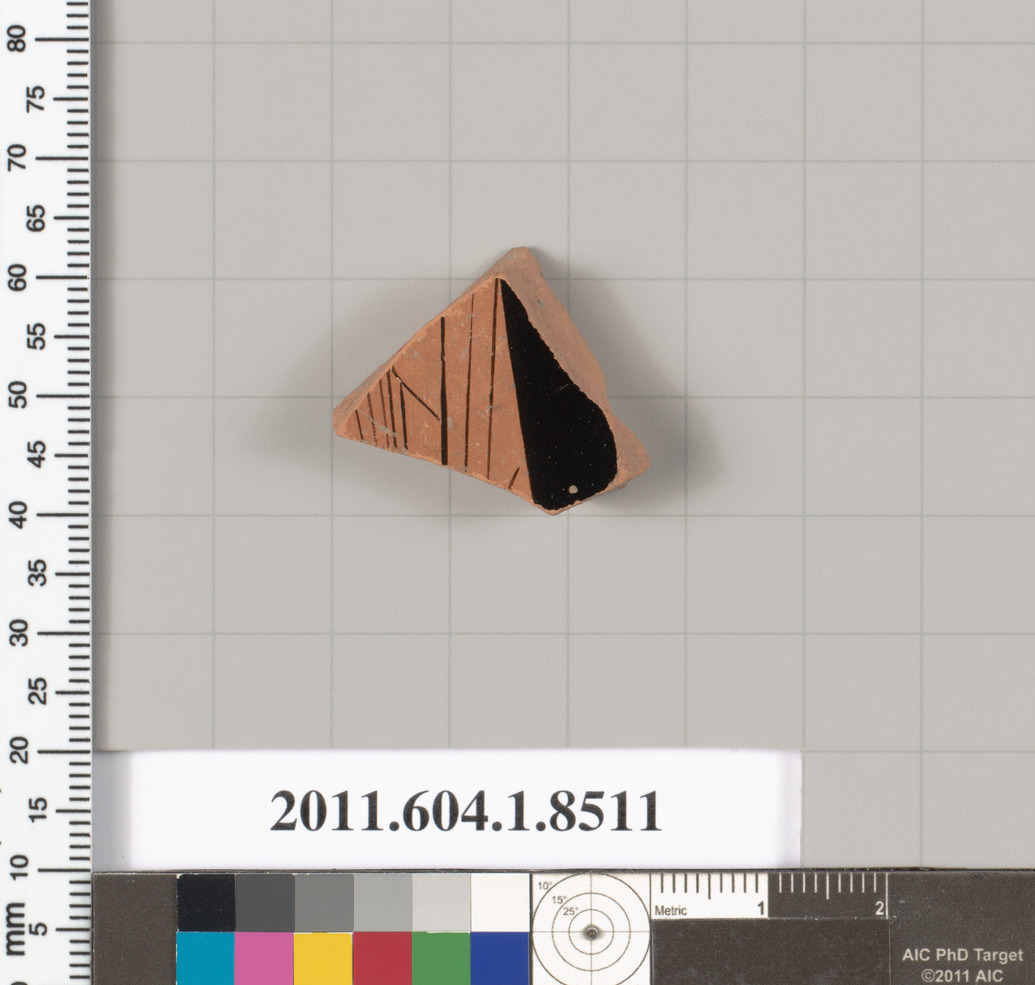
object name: kylix fragment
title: Terracotta fragment of a stemless kylix (drinking cup)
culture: greek, attic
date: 475-451 BCE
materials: terracotta